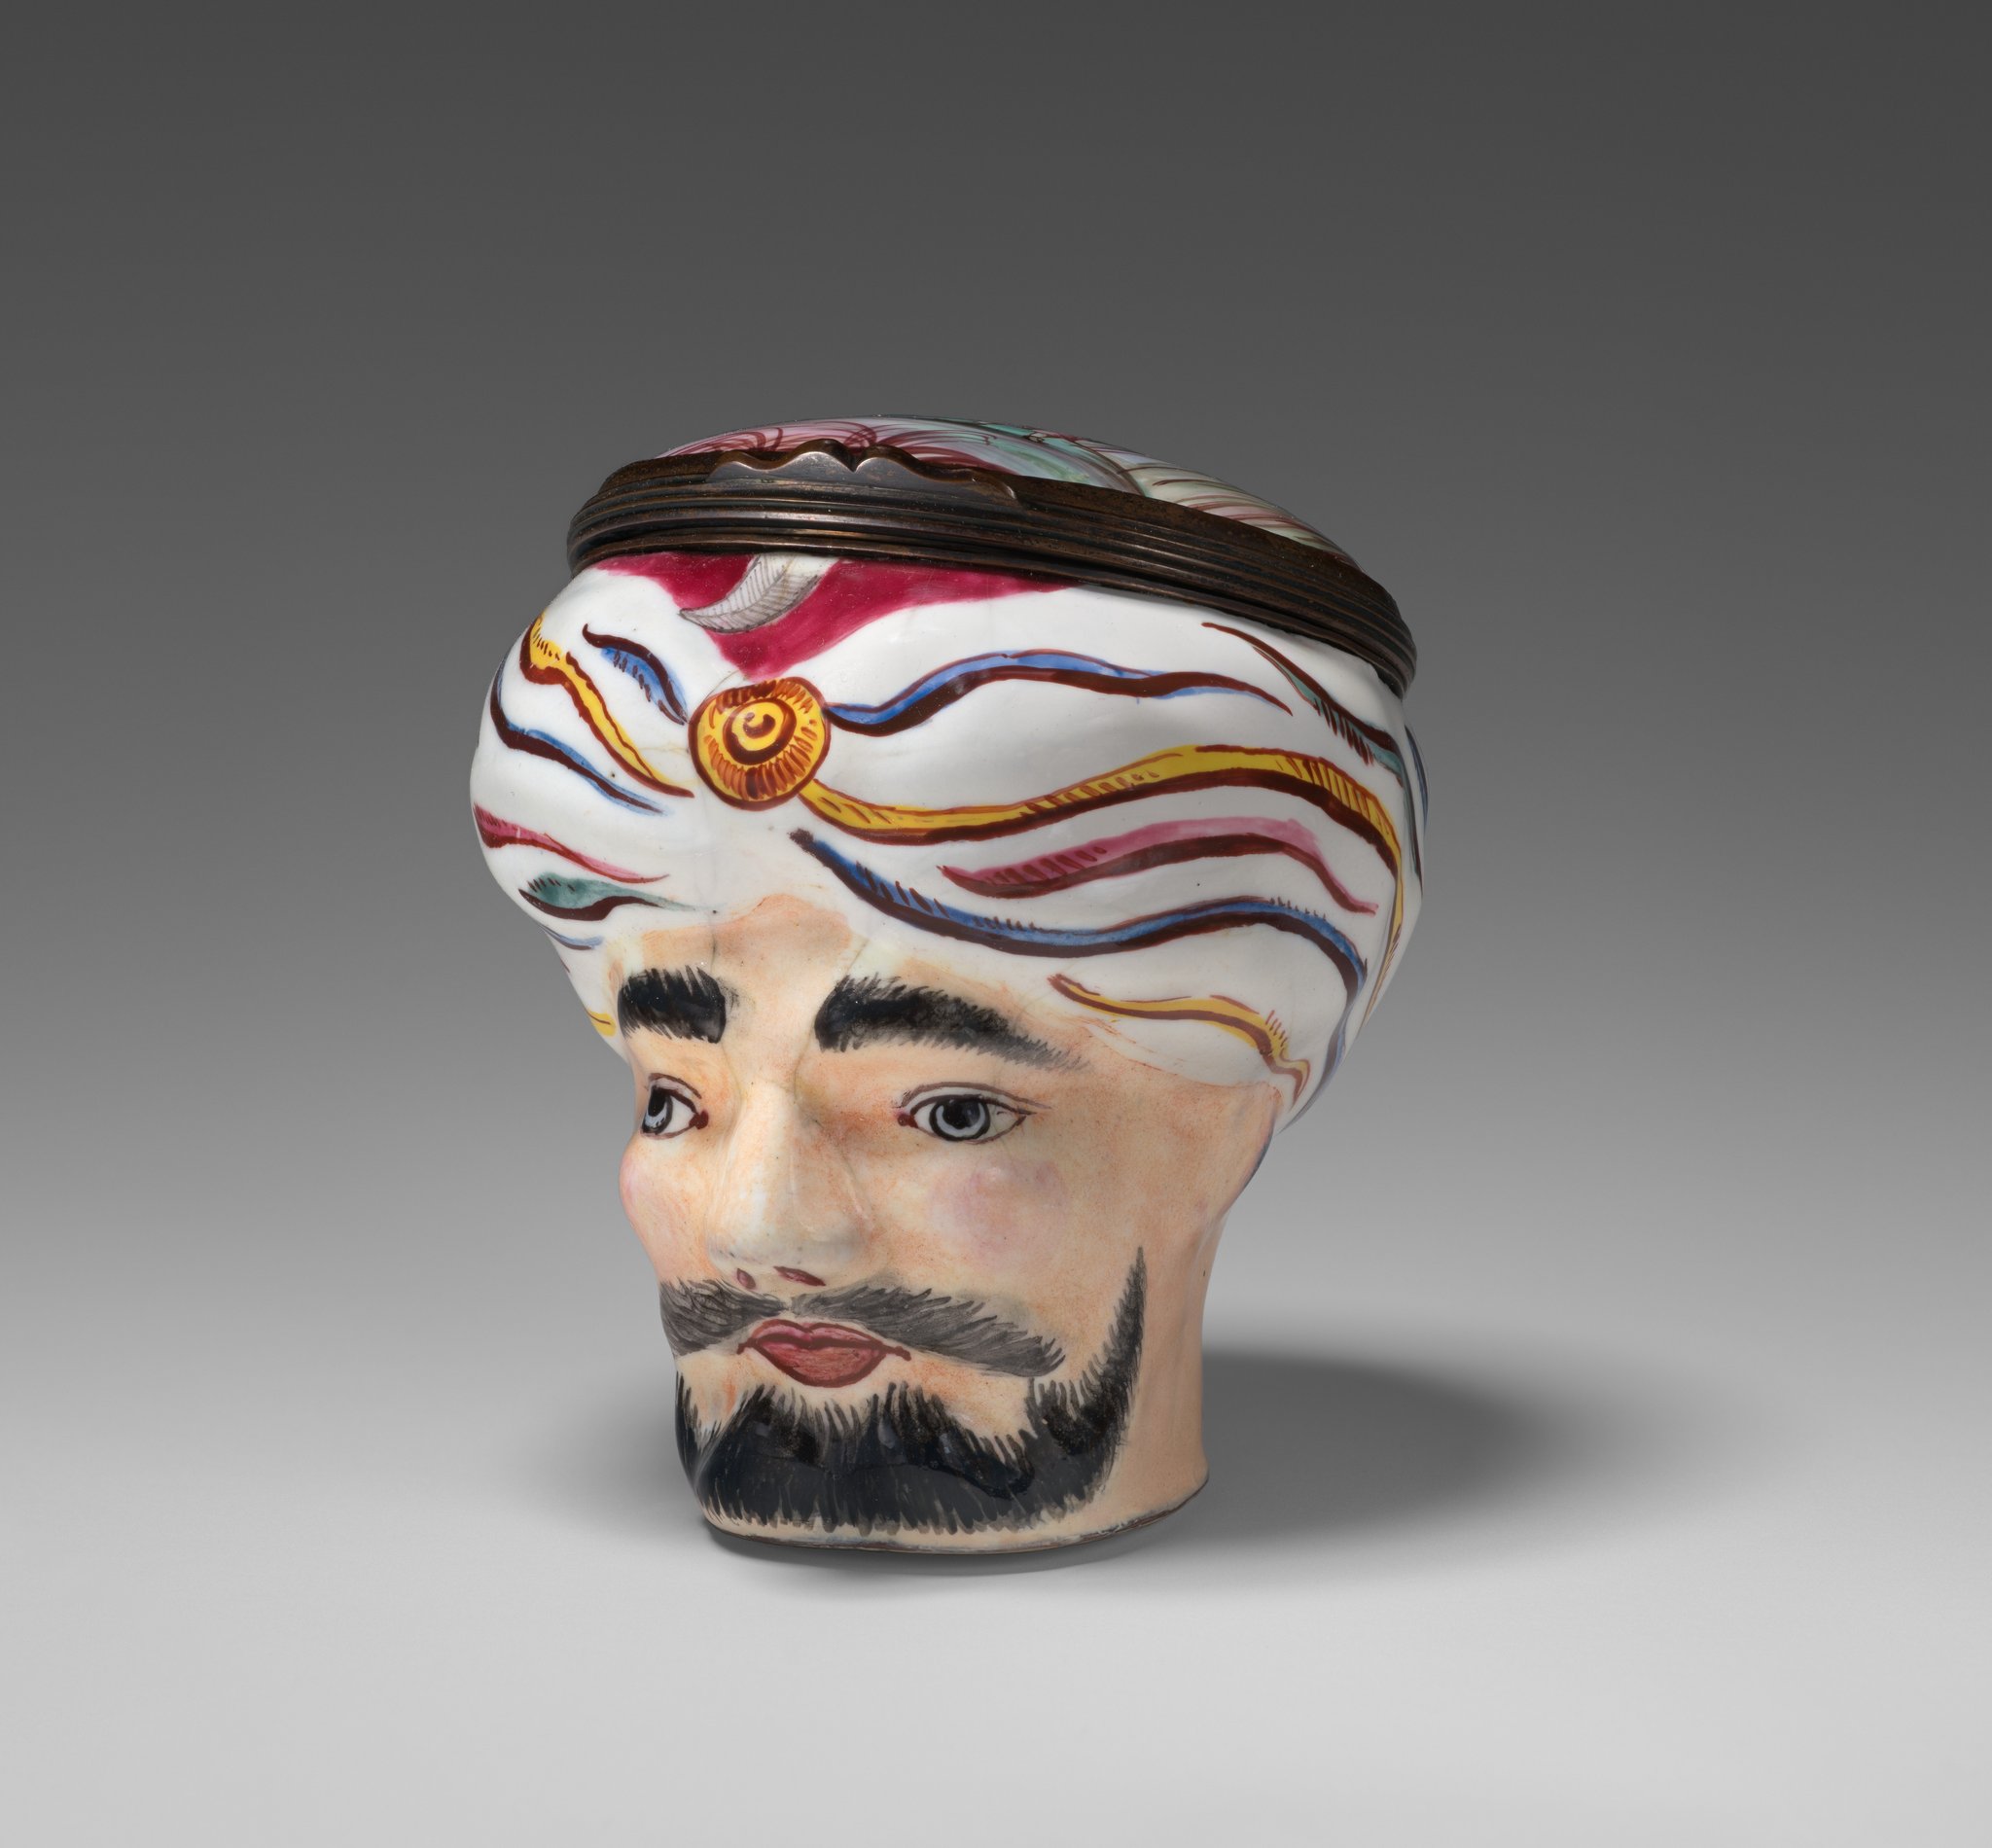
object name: bonbonnière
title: Head of a turbaned man bonbonnière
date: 1770-1780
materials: copper, enamel